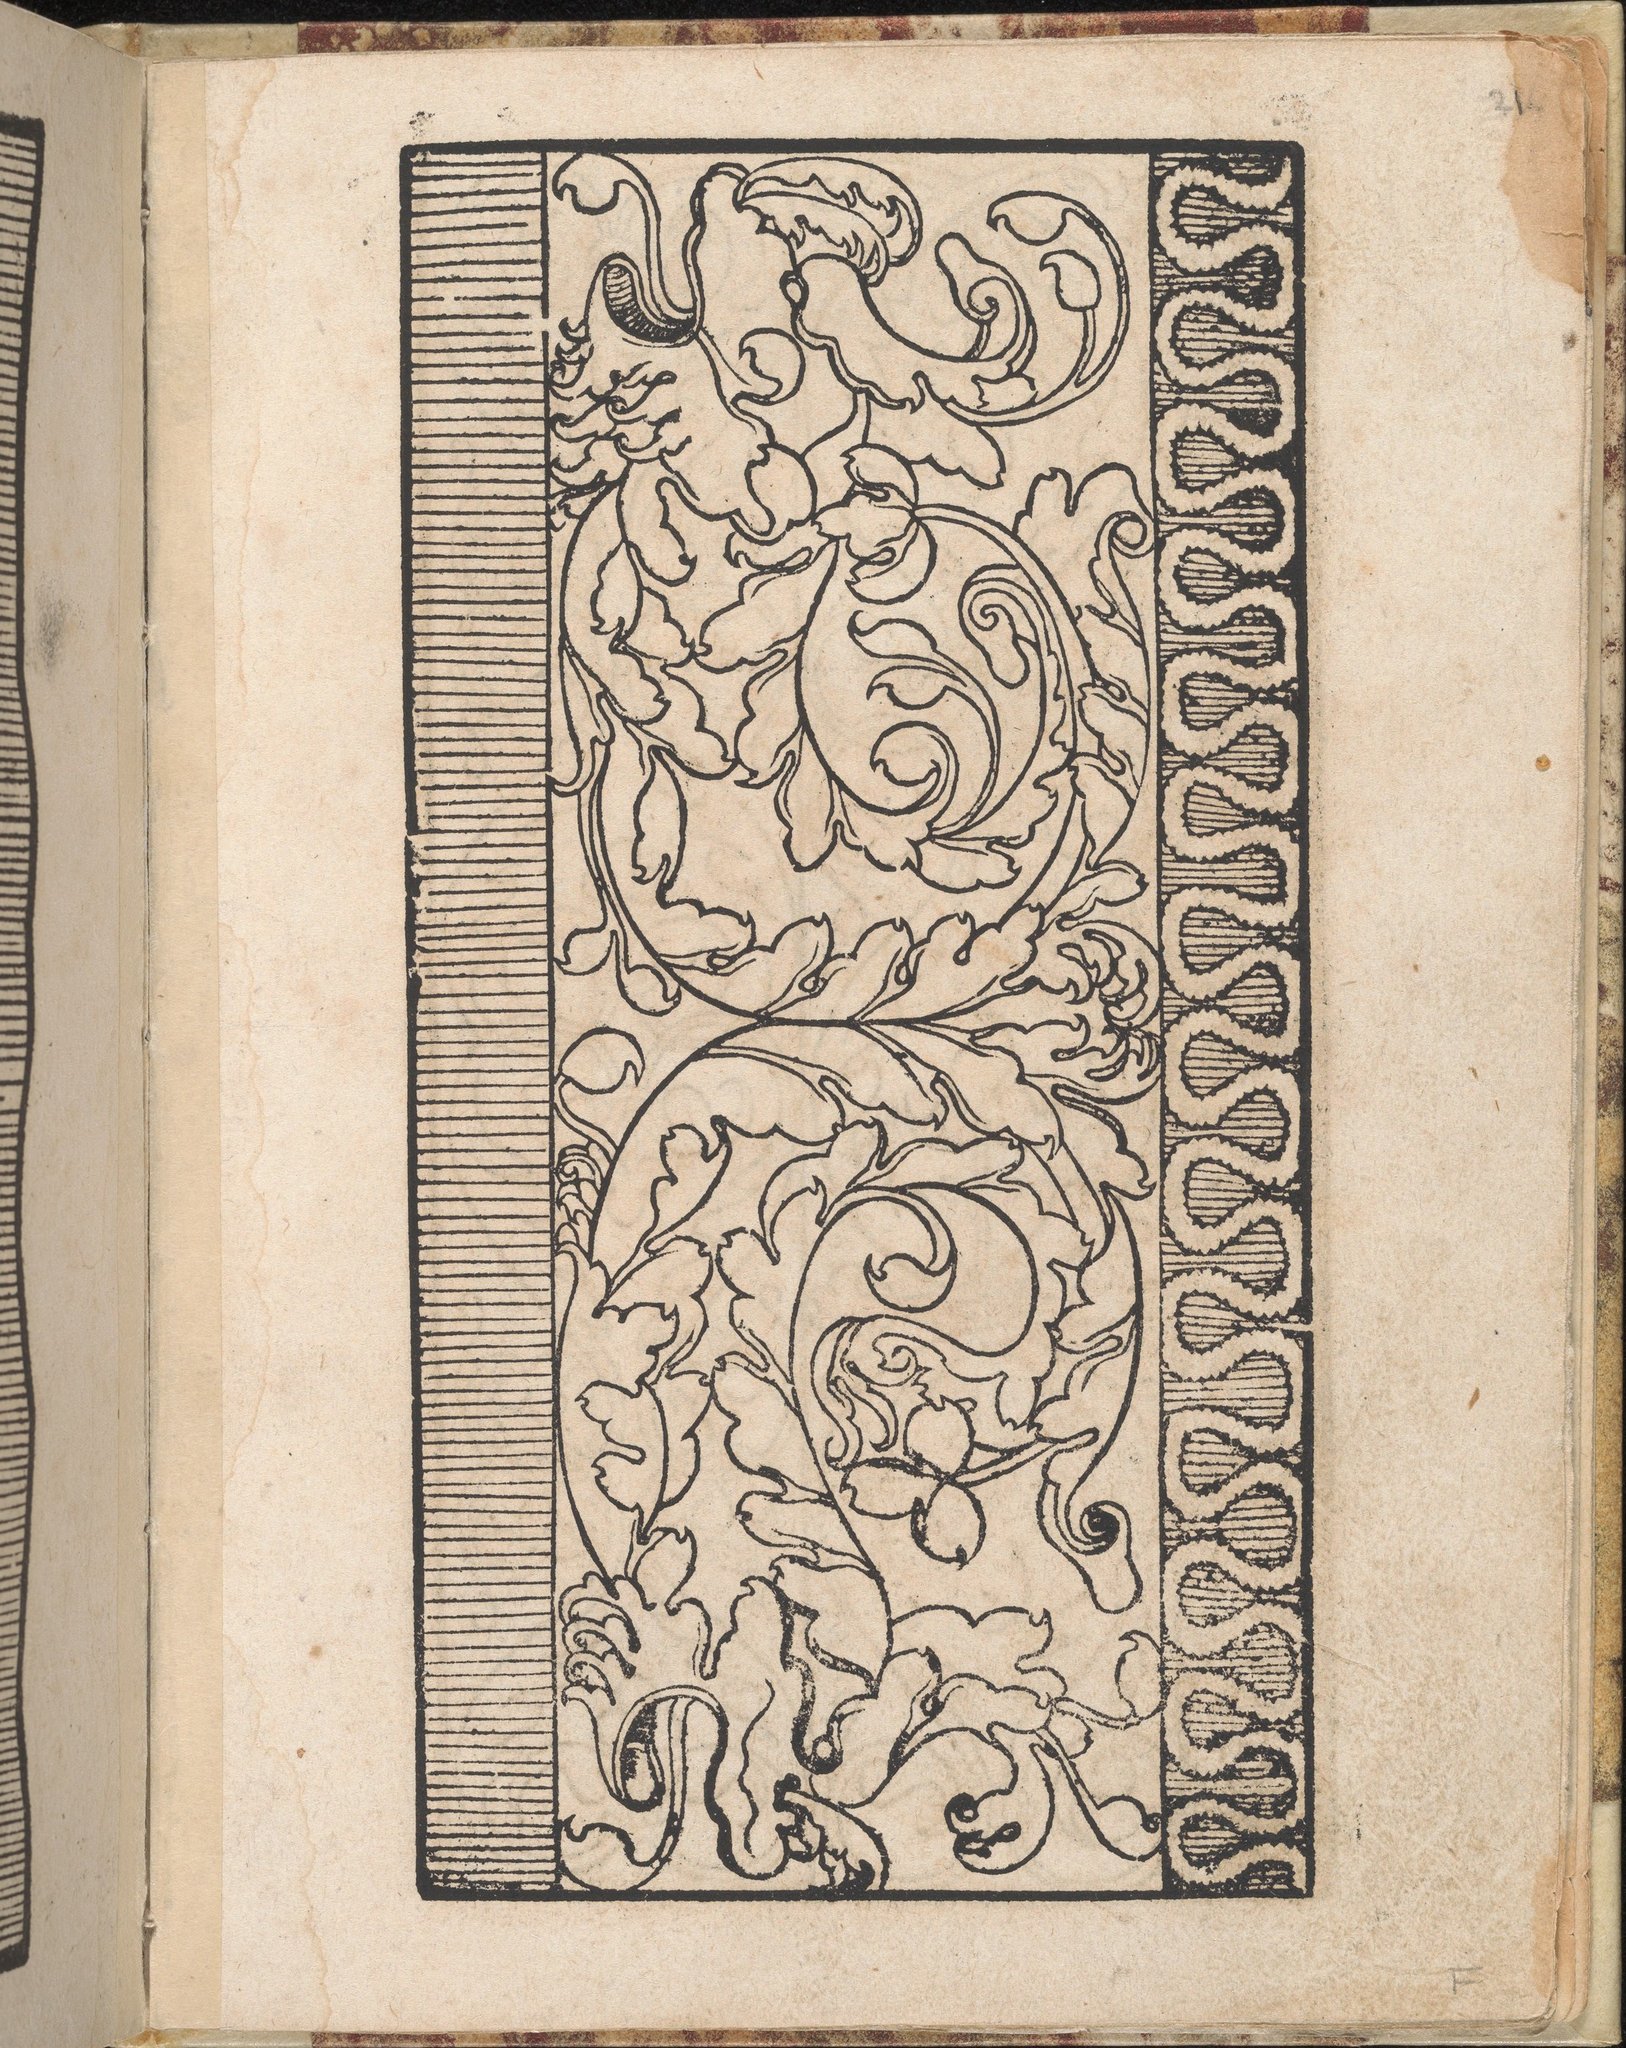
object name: book print ornament architecture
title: Ein new getruckt model Büchli...Page 20, verso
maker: johann schönsperger the younger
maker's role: publisher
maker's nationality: german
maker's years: 1490-1550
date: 1529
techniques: woodcut